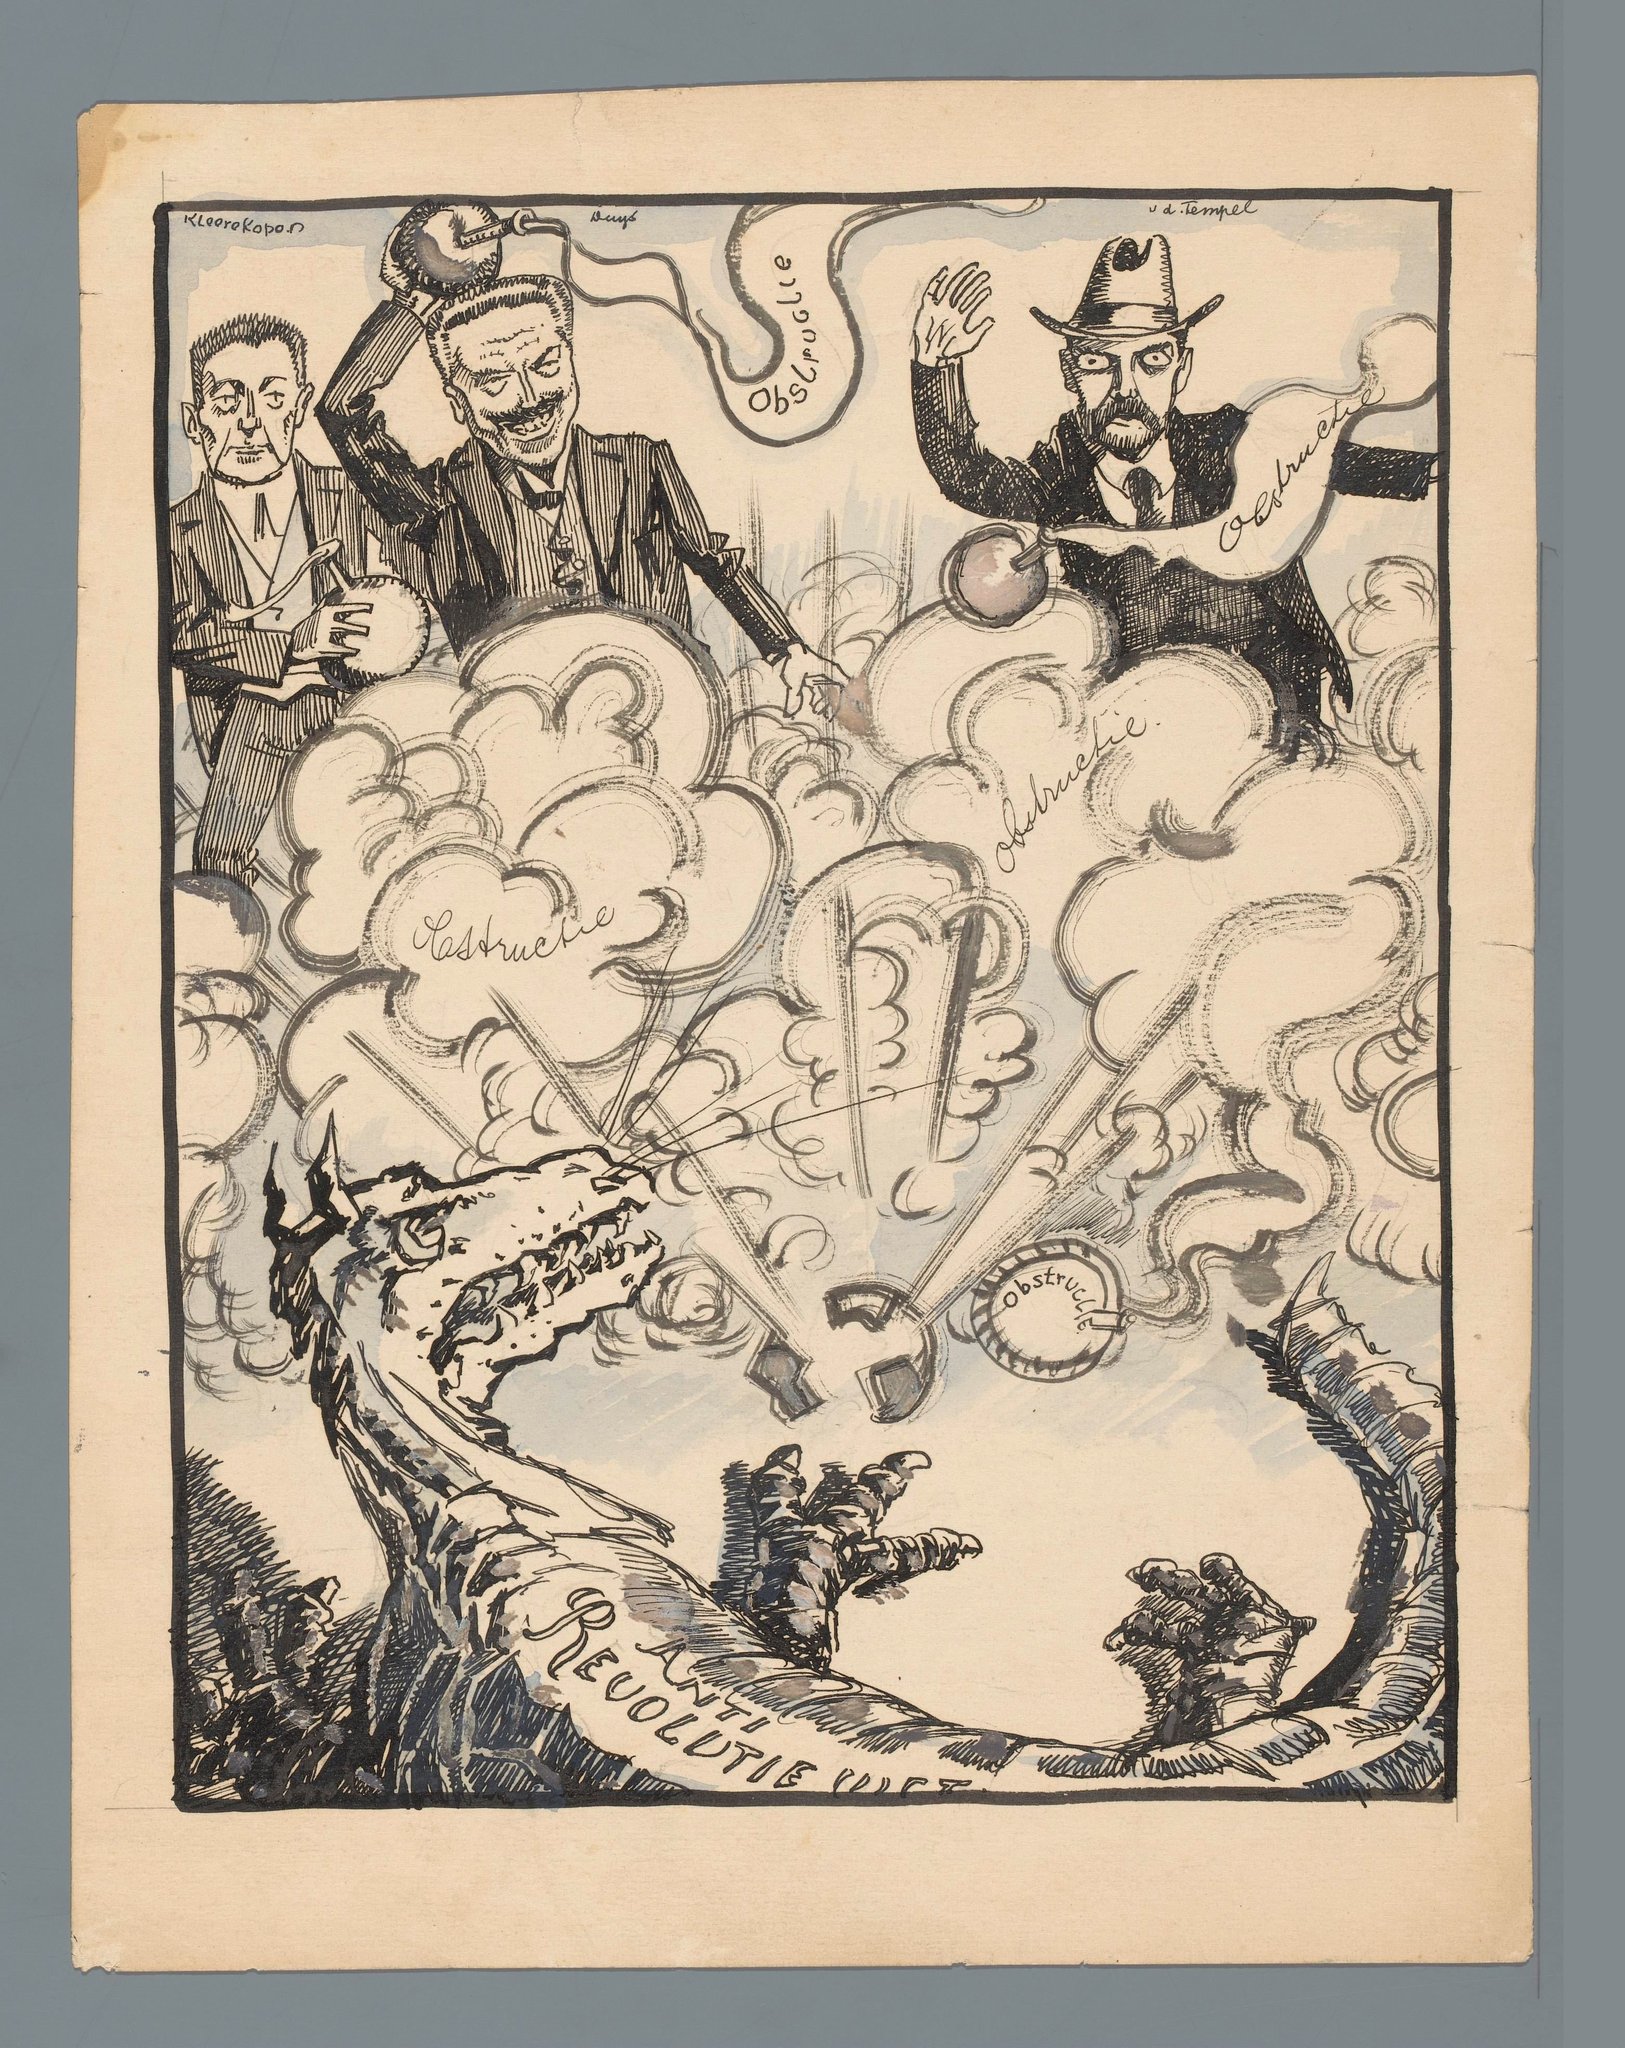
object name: drawing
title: Obstructie tegen de anti-revolutie wet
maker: patricq kroon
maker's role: draughtsman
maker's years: 1862-1941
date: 1920-1930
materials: ink, paper, pencil, watercolor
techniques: brush, pen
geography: netherlands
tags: dragon, political caricatures and satires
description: Verschillende sociaal-democratische politici (Kleerekoper, Duys, Van de Tempel) werpen bommen naar een draak aangeduid als 'Anti Revolutie Wet'. Ontwerp voor een politieke spotprent.